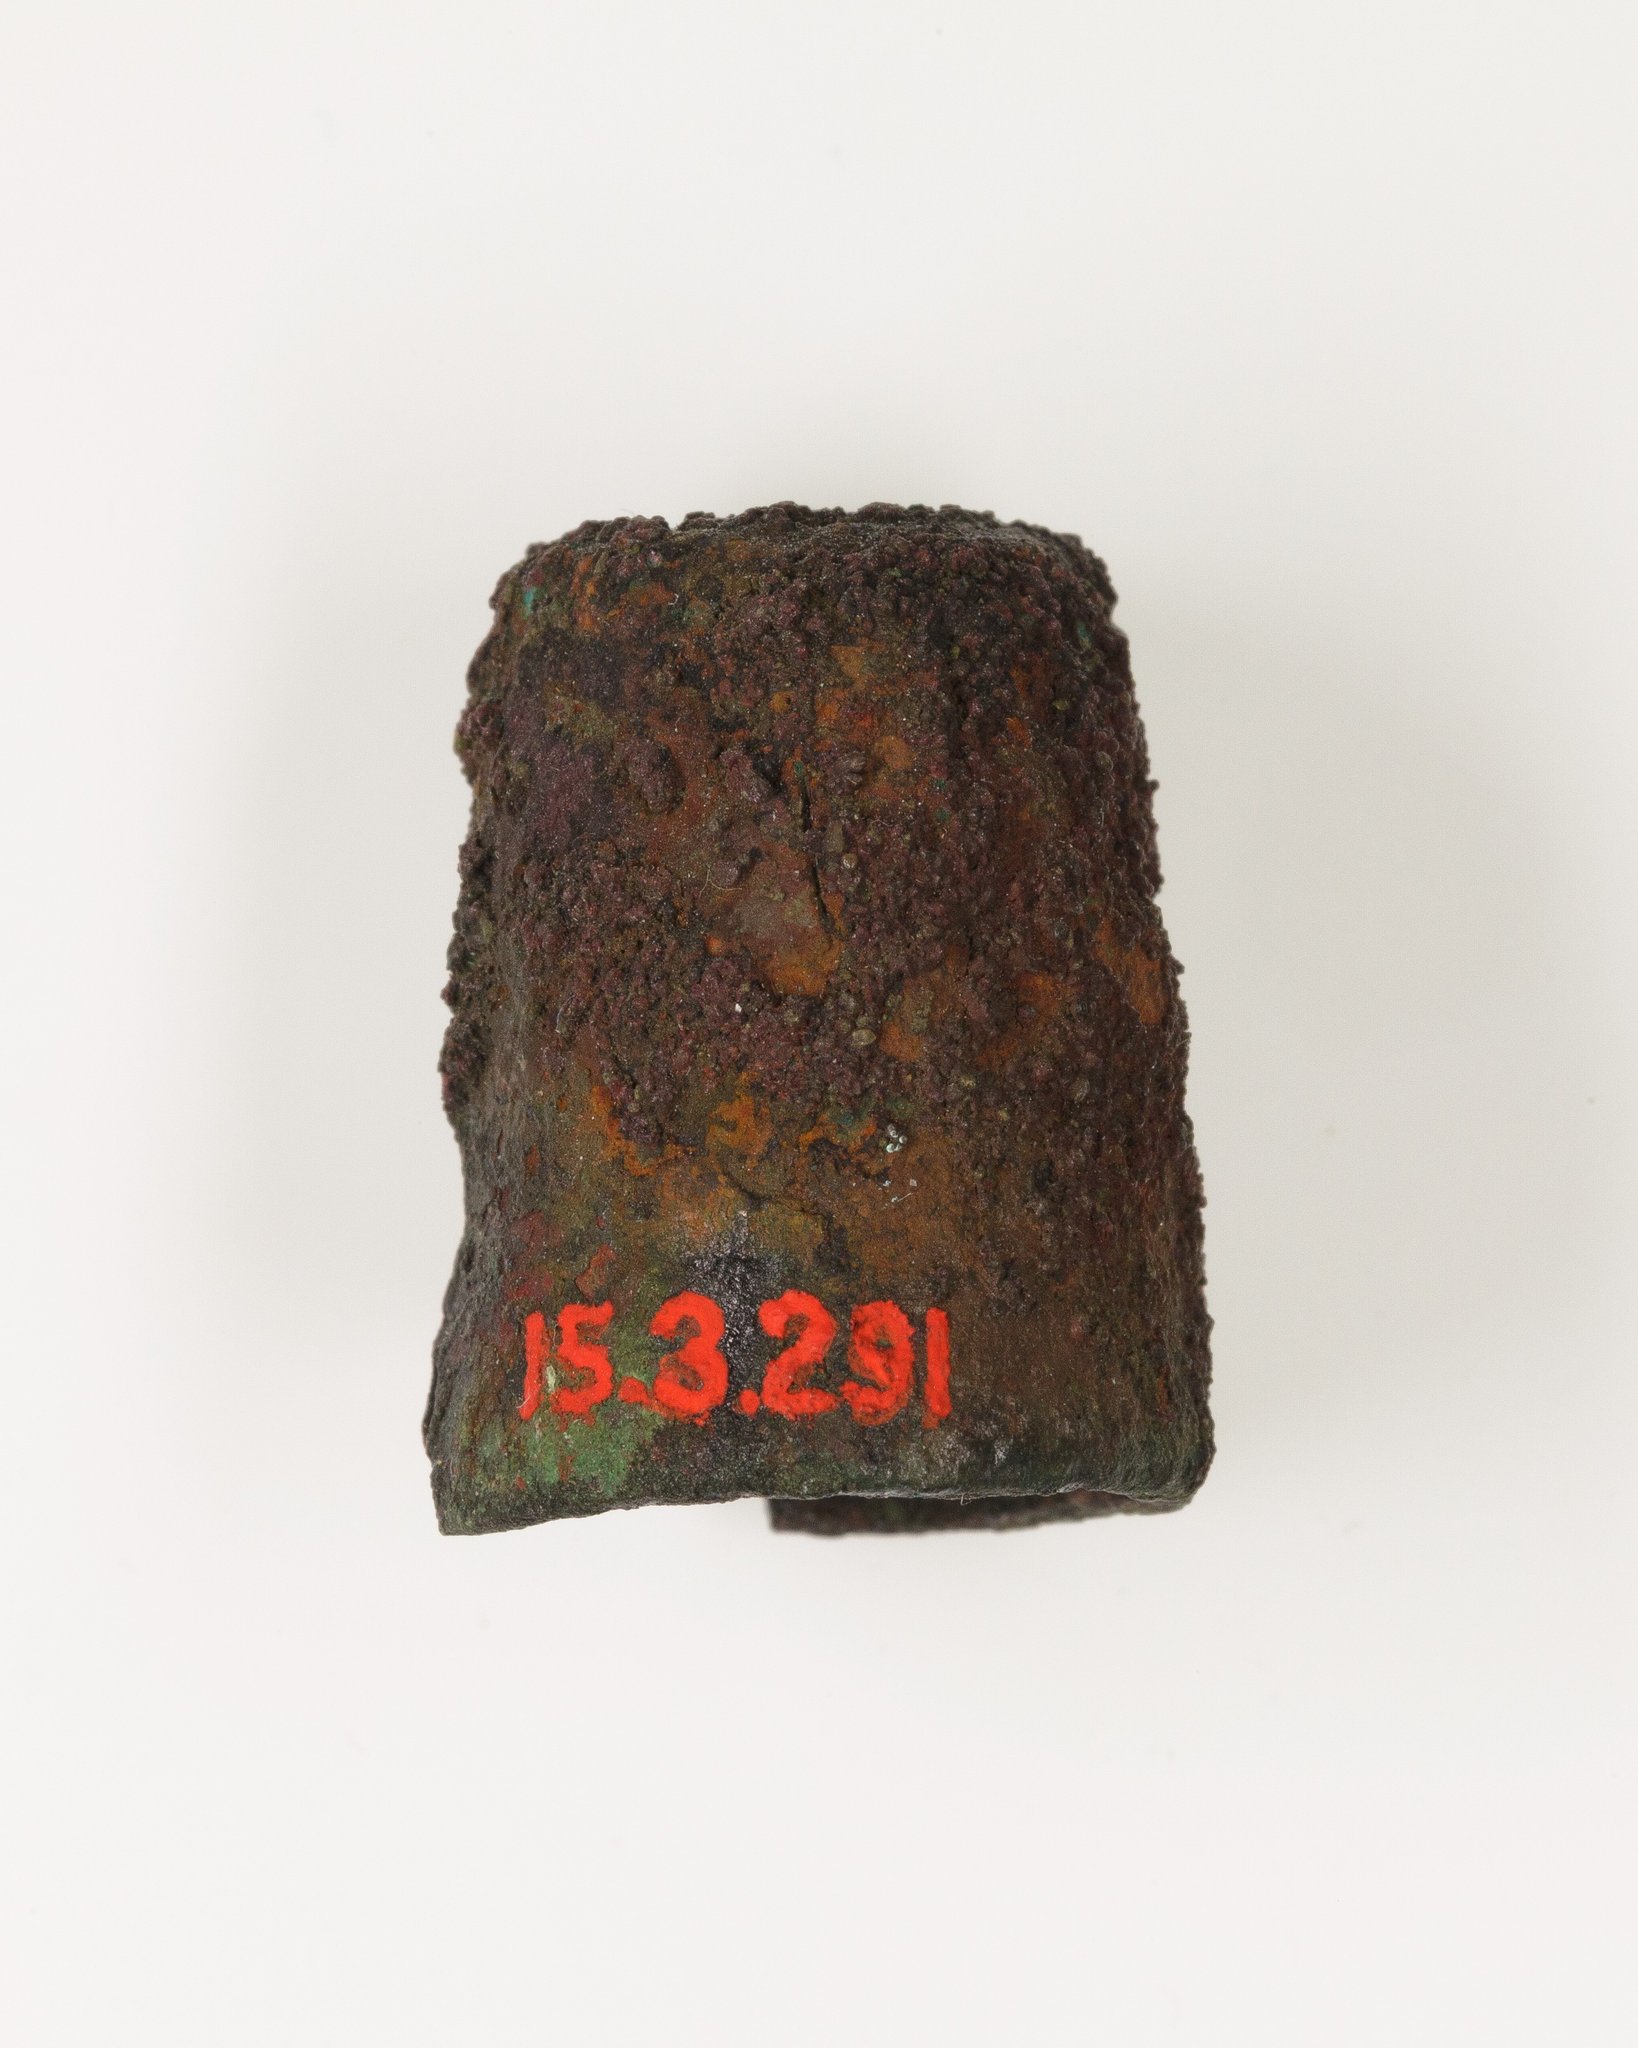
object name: ferrule, stick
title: Ferrule of stick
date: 1850-1750 BCE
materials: bronze, wood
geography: egypt